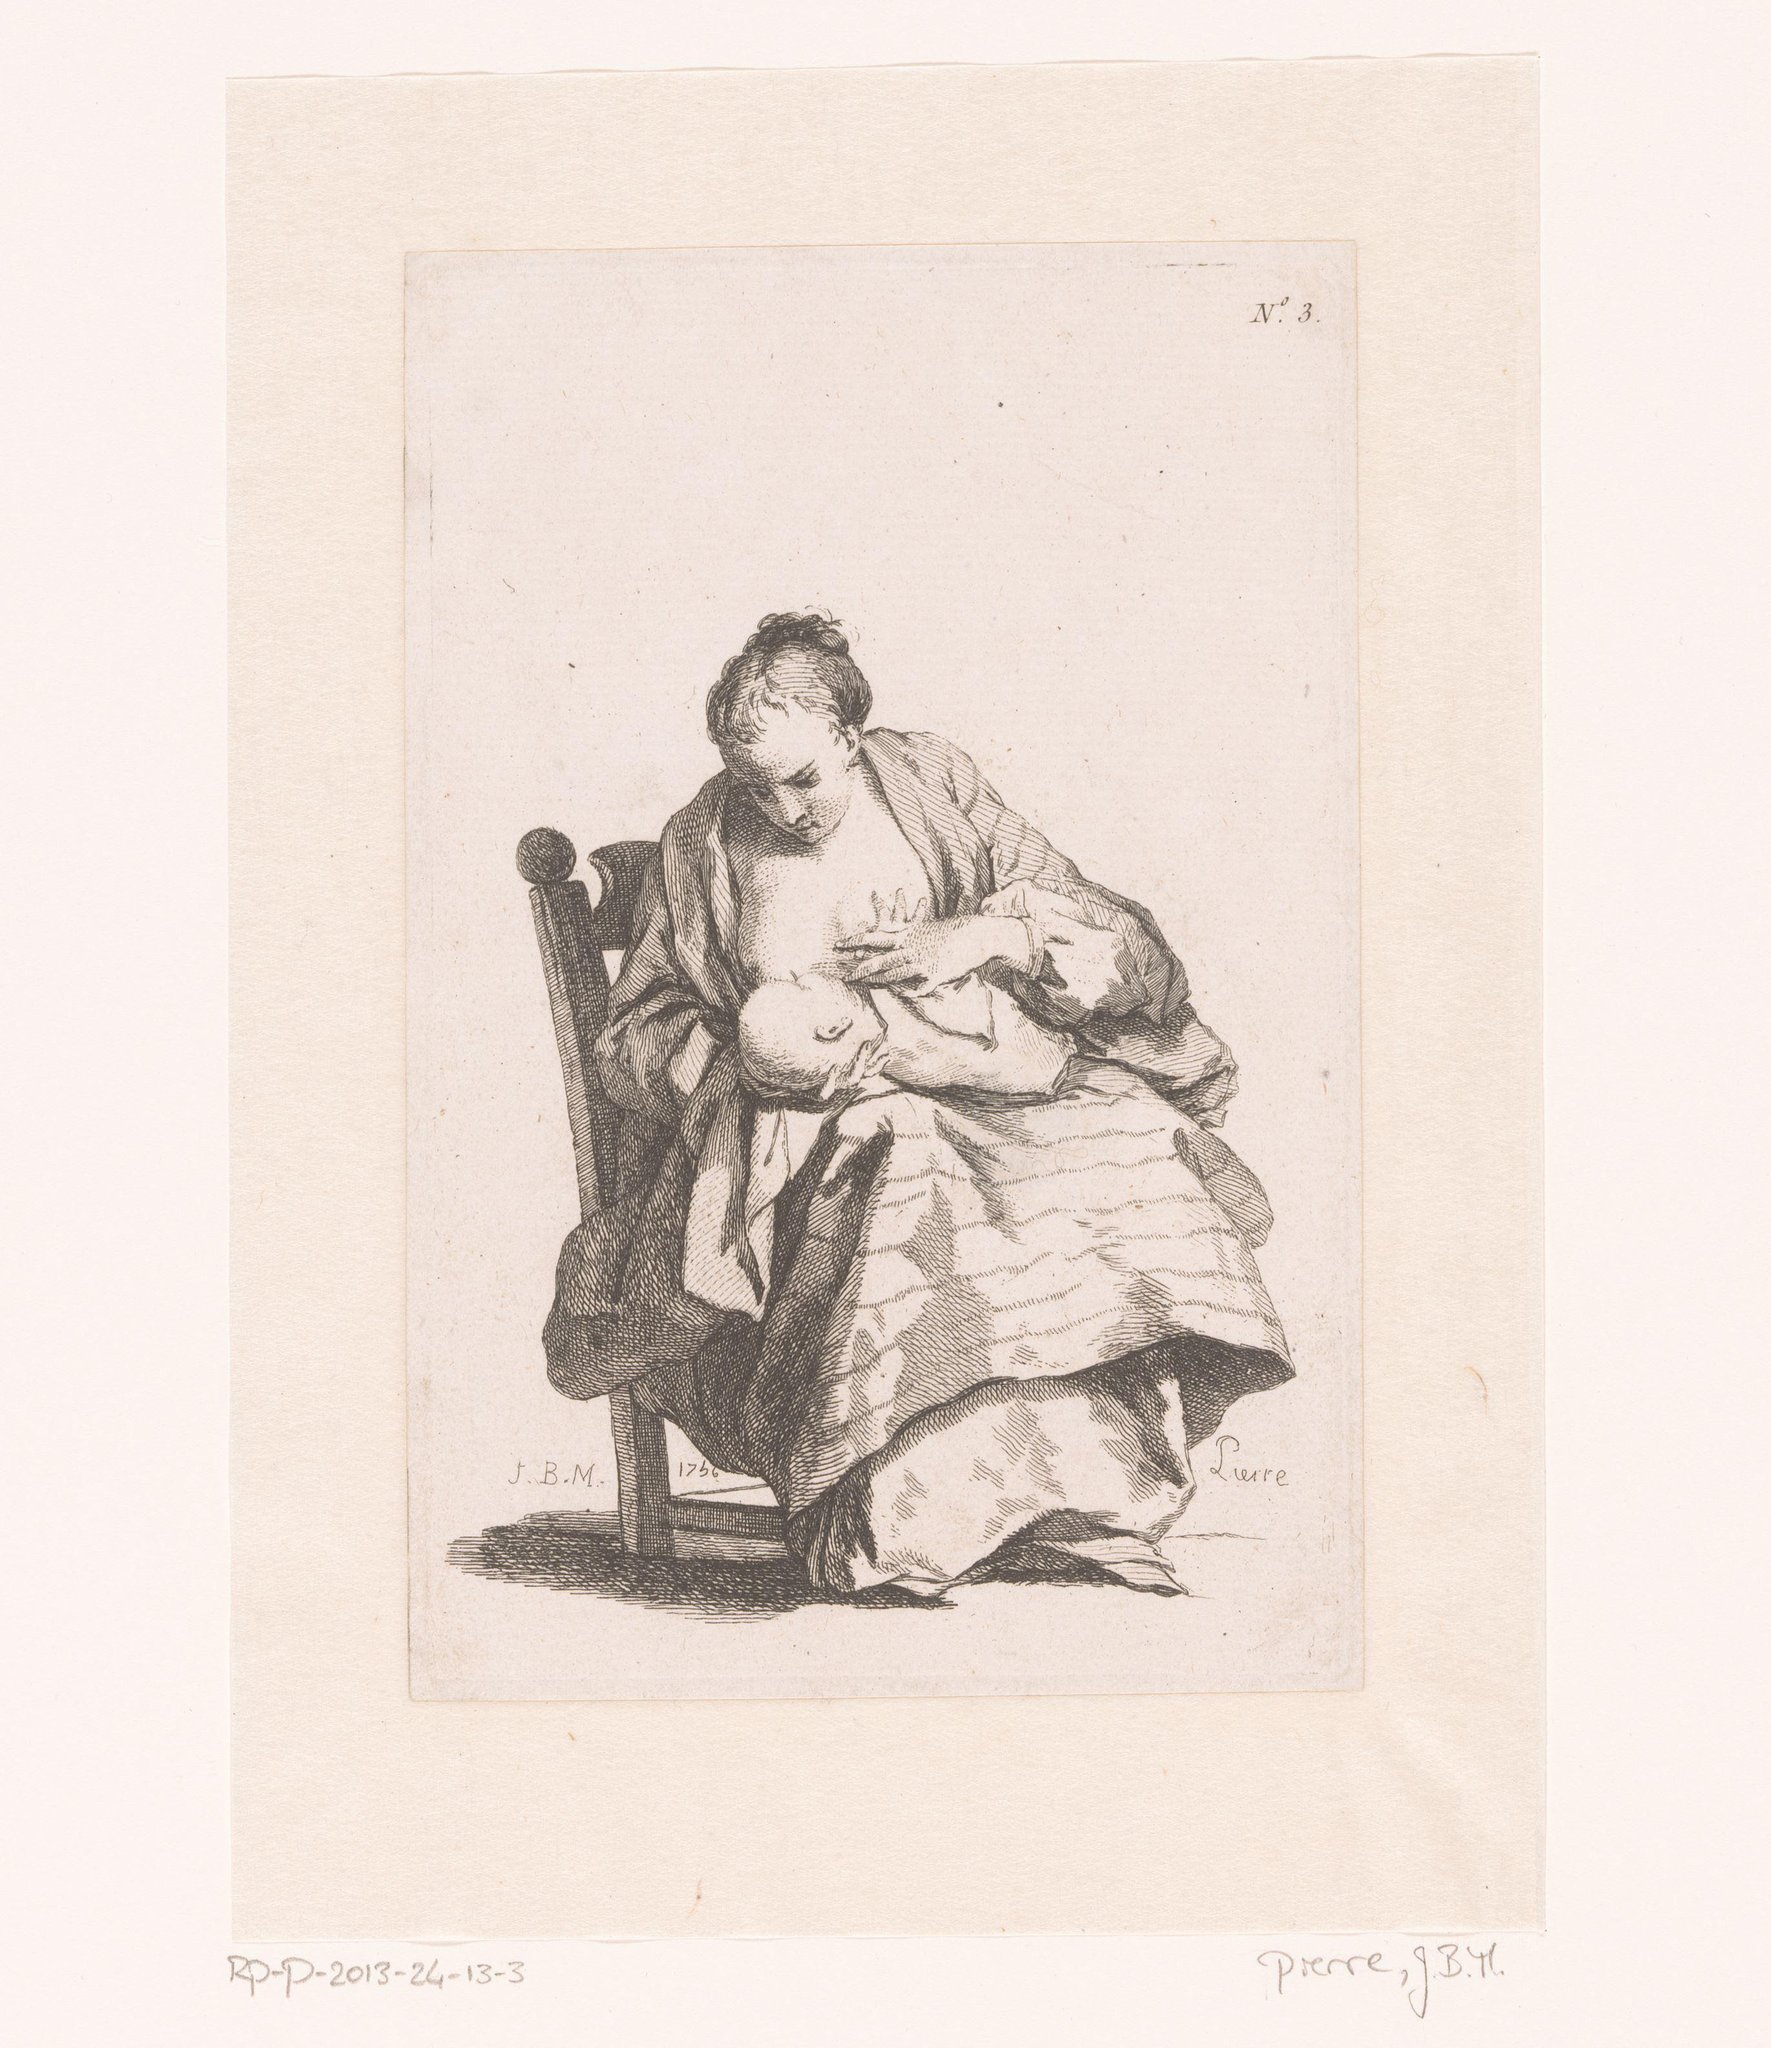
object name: print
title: Mensen uit de arme bevolking van Rome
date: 1756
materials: paper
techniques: etching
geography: paris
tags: nursing, suckling, the poor, rome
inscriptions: collector's mark: Lugt 5f, collector's mark: Lugt 2228, collector's mark: Lugt 2760